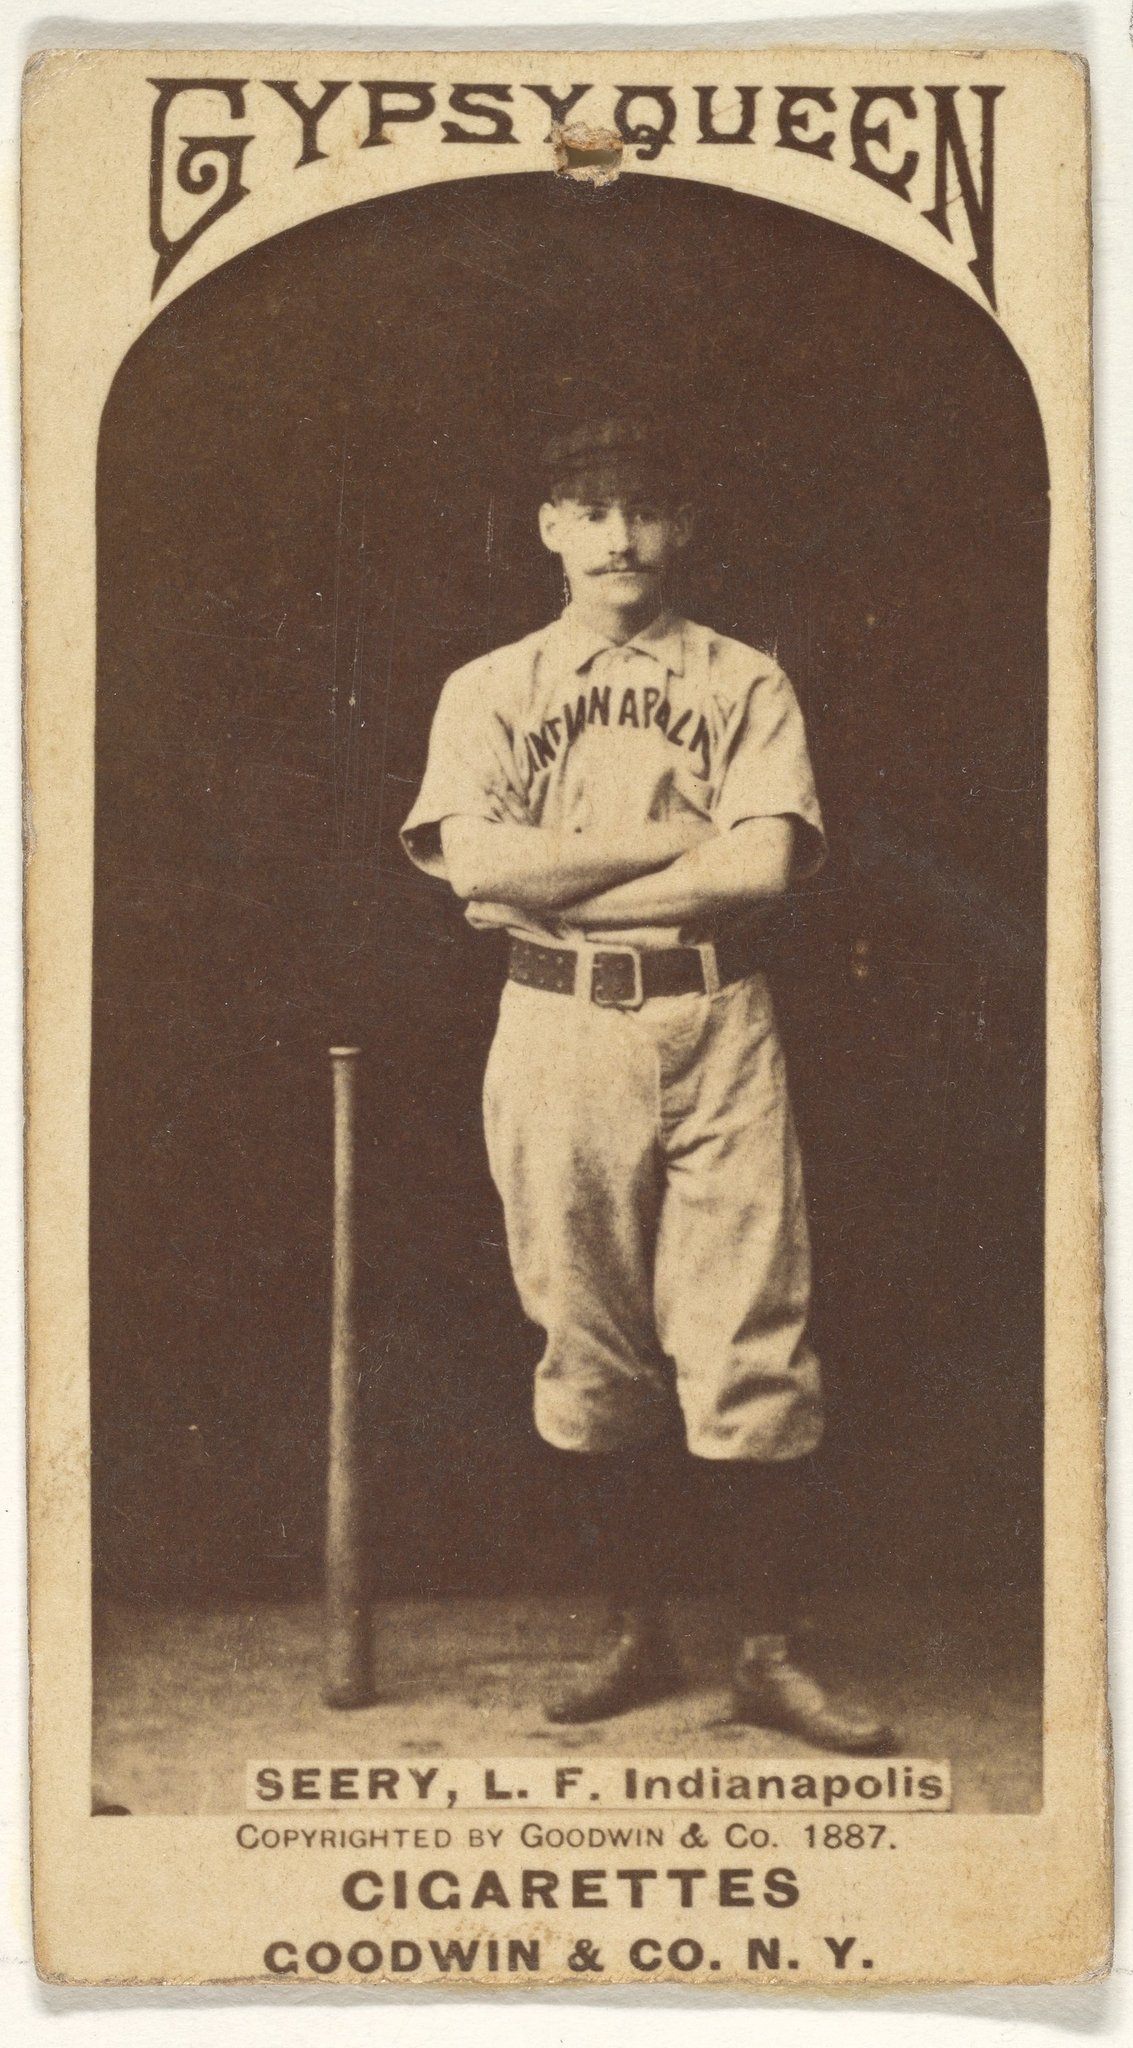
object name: baseball card, photograph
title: Seery, Left Field, Indianapolis, from the Old Judge series (N172) for Old Judge Cigarettes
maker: goodwin & company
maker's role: publisher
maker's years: 1850-1950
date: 1887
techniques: albumen silver print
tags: men,portraits,baseball,athletes